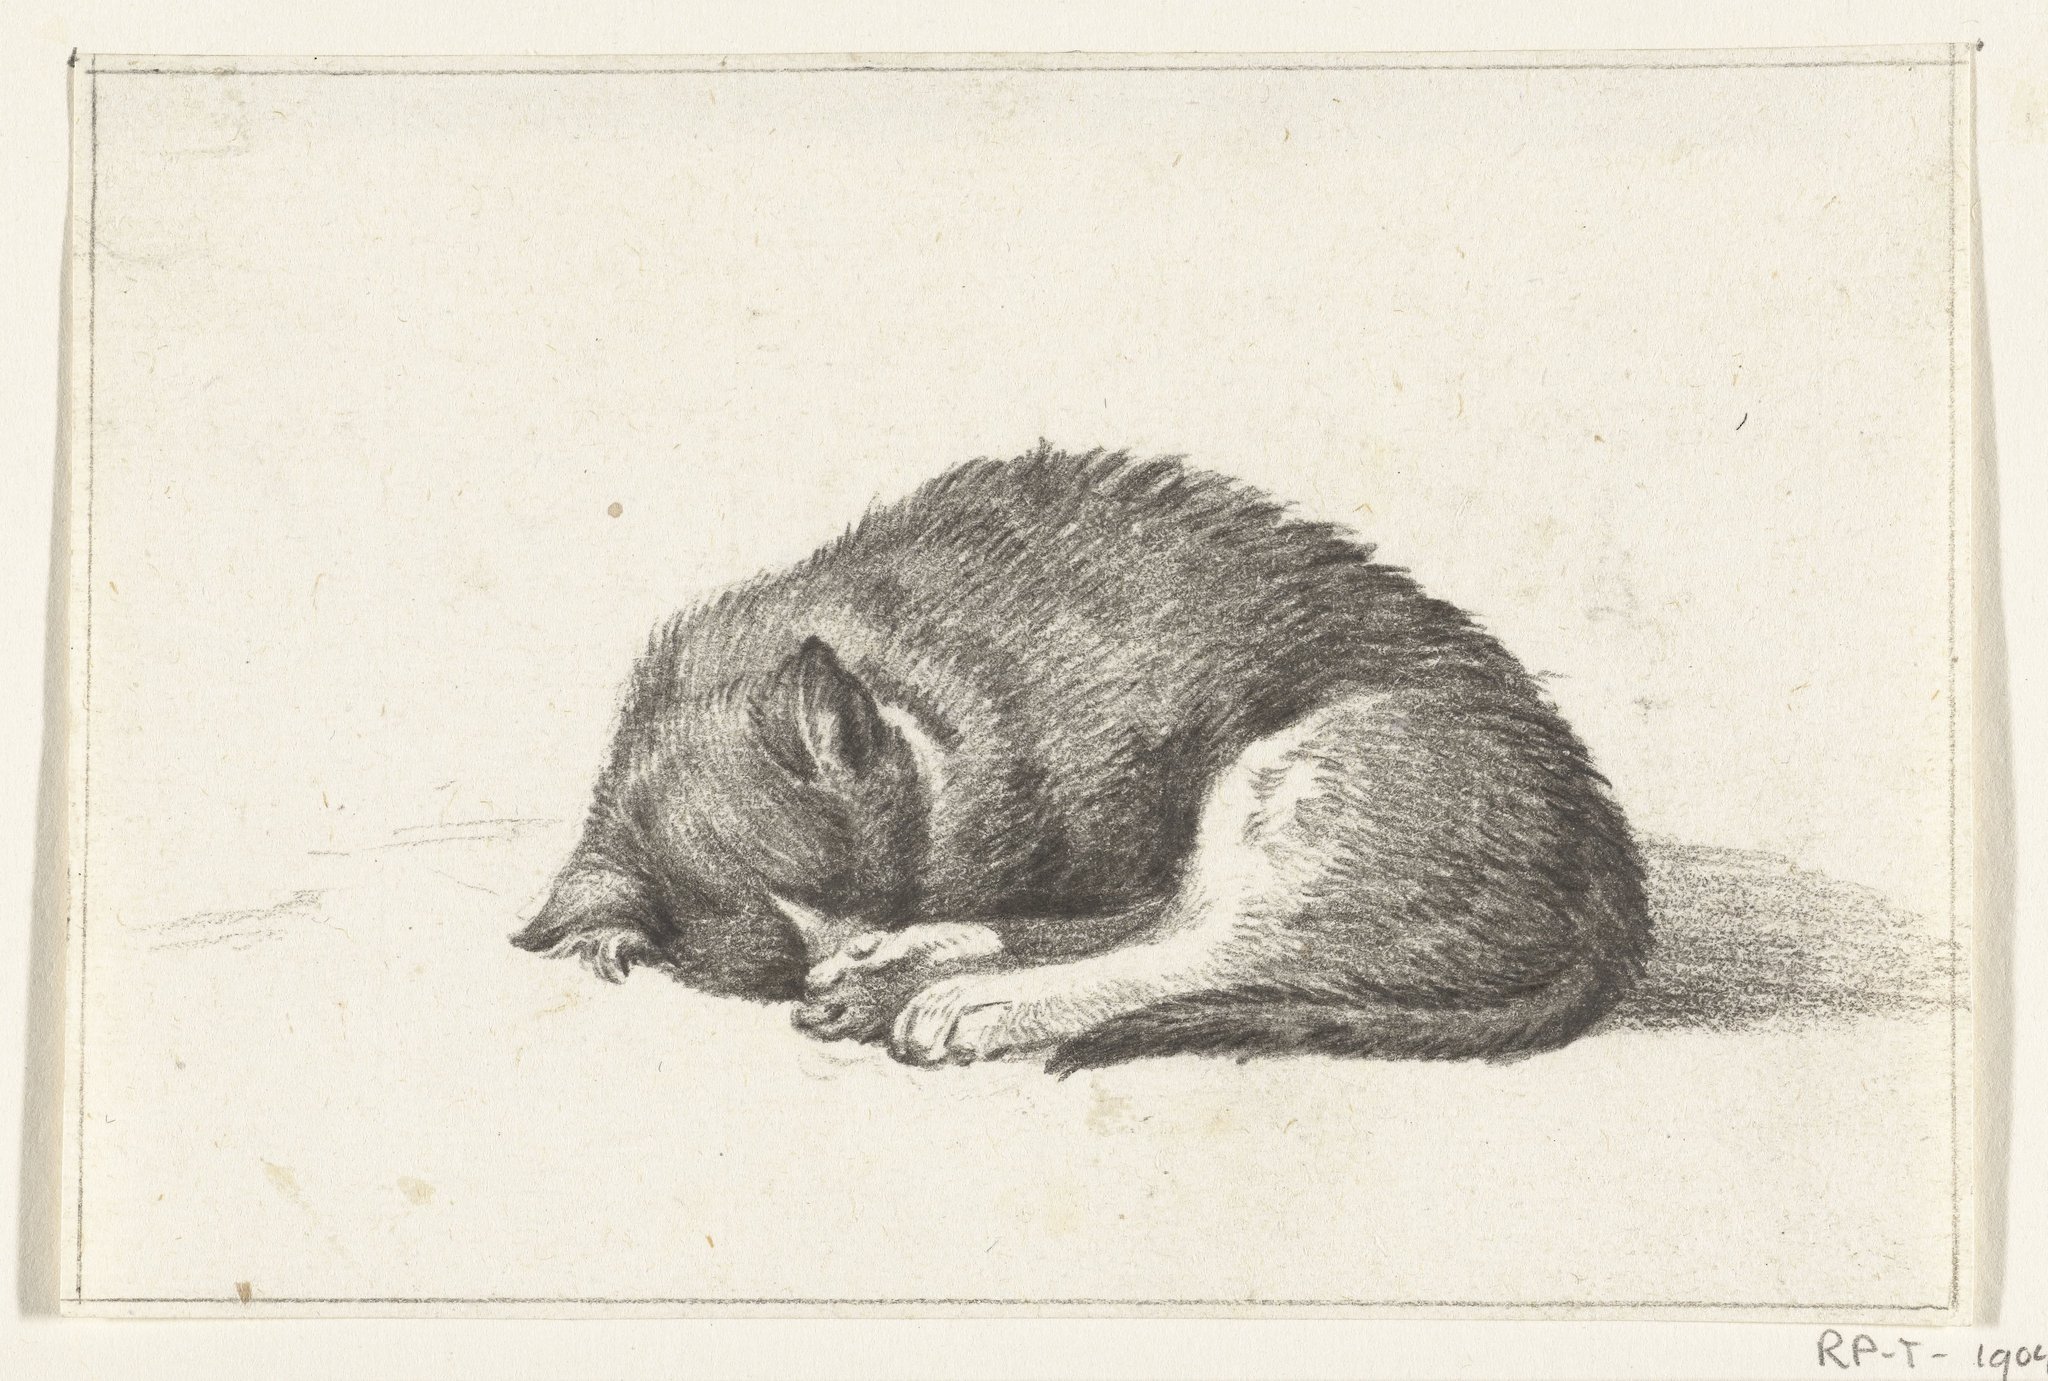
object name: drawing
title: Opgerold liggende, slapende kat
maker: jean bernard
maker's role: draughtsman, print maker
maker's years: 1765-1833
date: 1775-1833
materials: chalk, paper, pencil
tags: cat